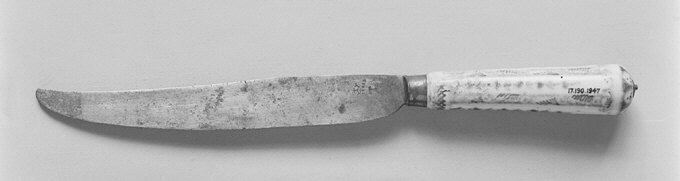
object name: knife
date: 1734-1766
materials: soft paste porcelain, steel